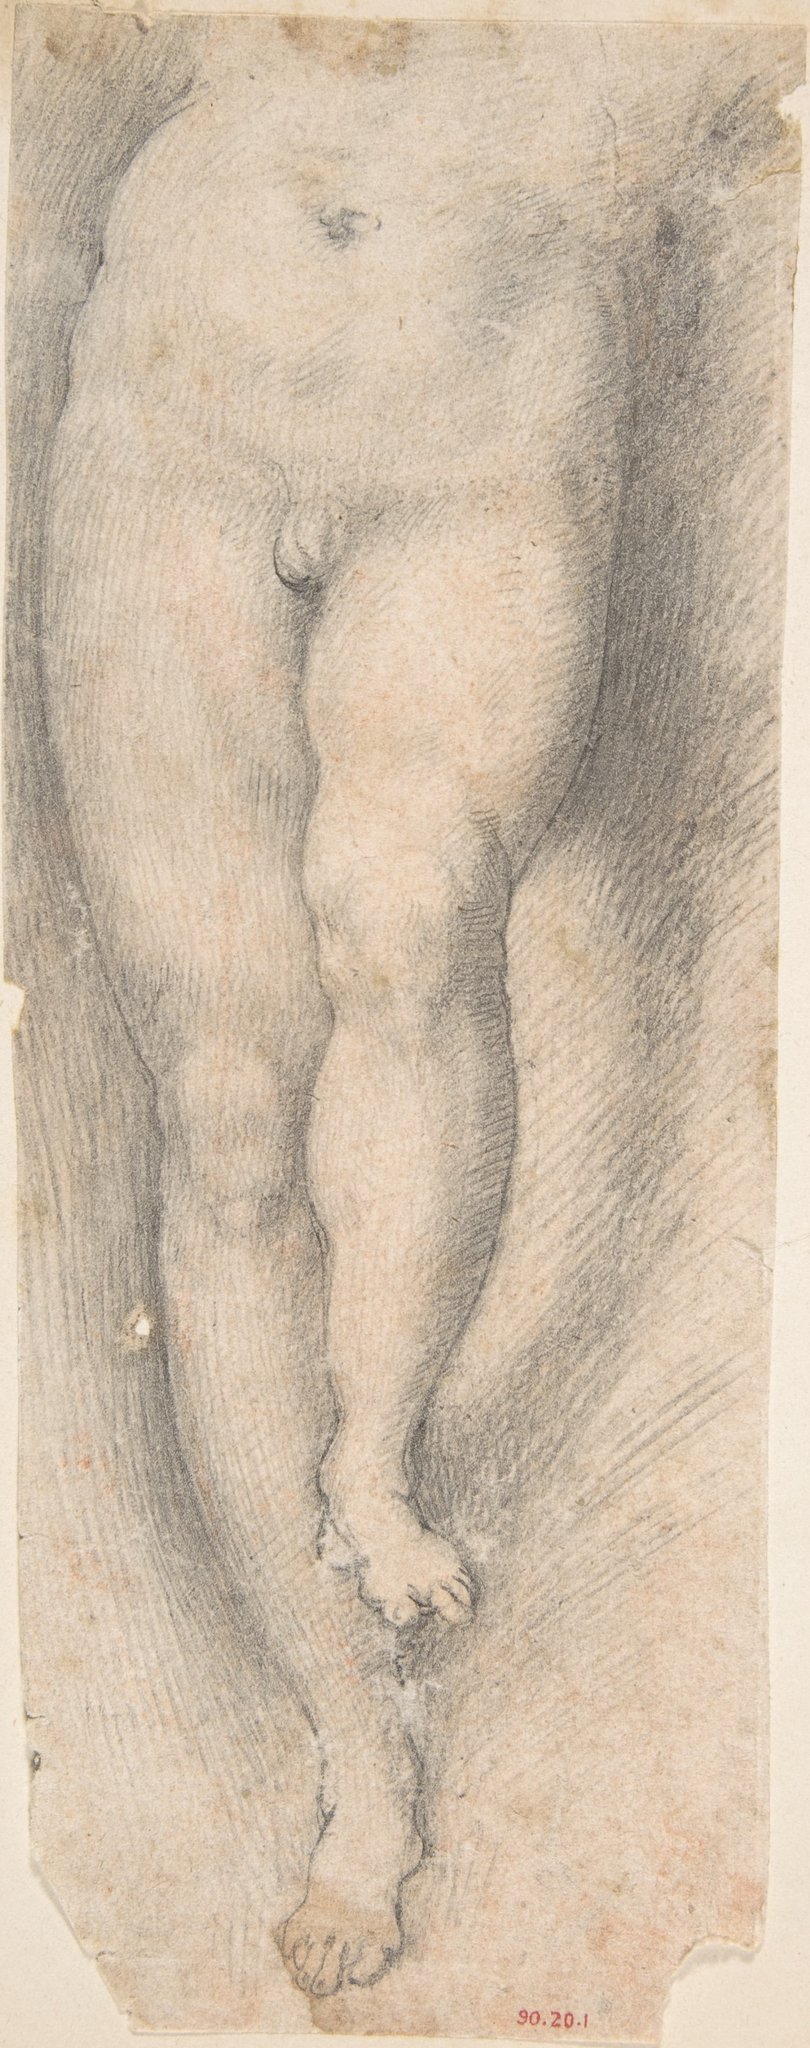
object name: drawing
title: Study for Lower Part of Torso and Legs of a Young Boy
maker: pomarancio (cristoforo roncalli)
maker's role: artist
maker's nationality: italian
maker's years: 1553-1626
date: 1568-1640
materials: chalk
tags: boys,male nudes